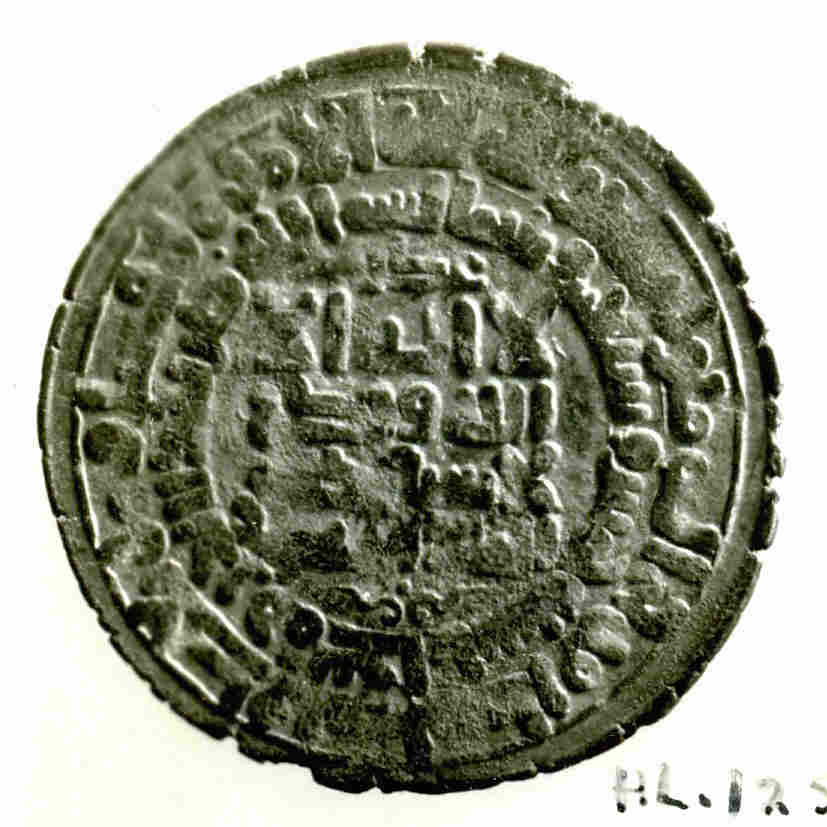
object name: coin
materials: silver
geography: uzbekistan